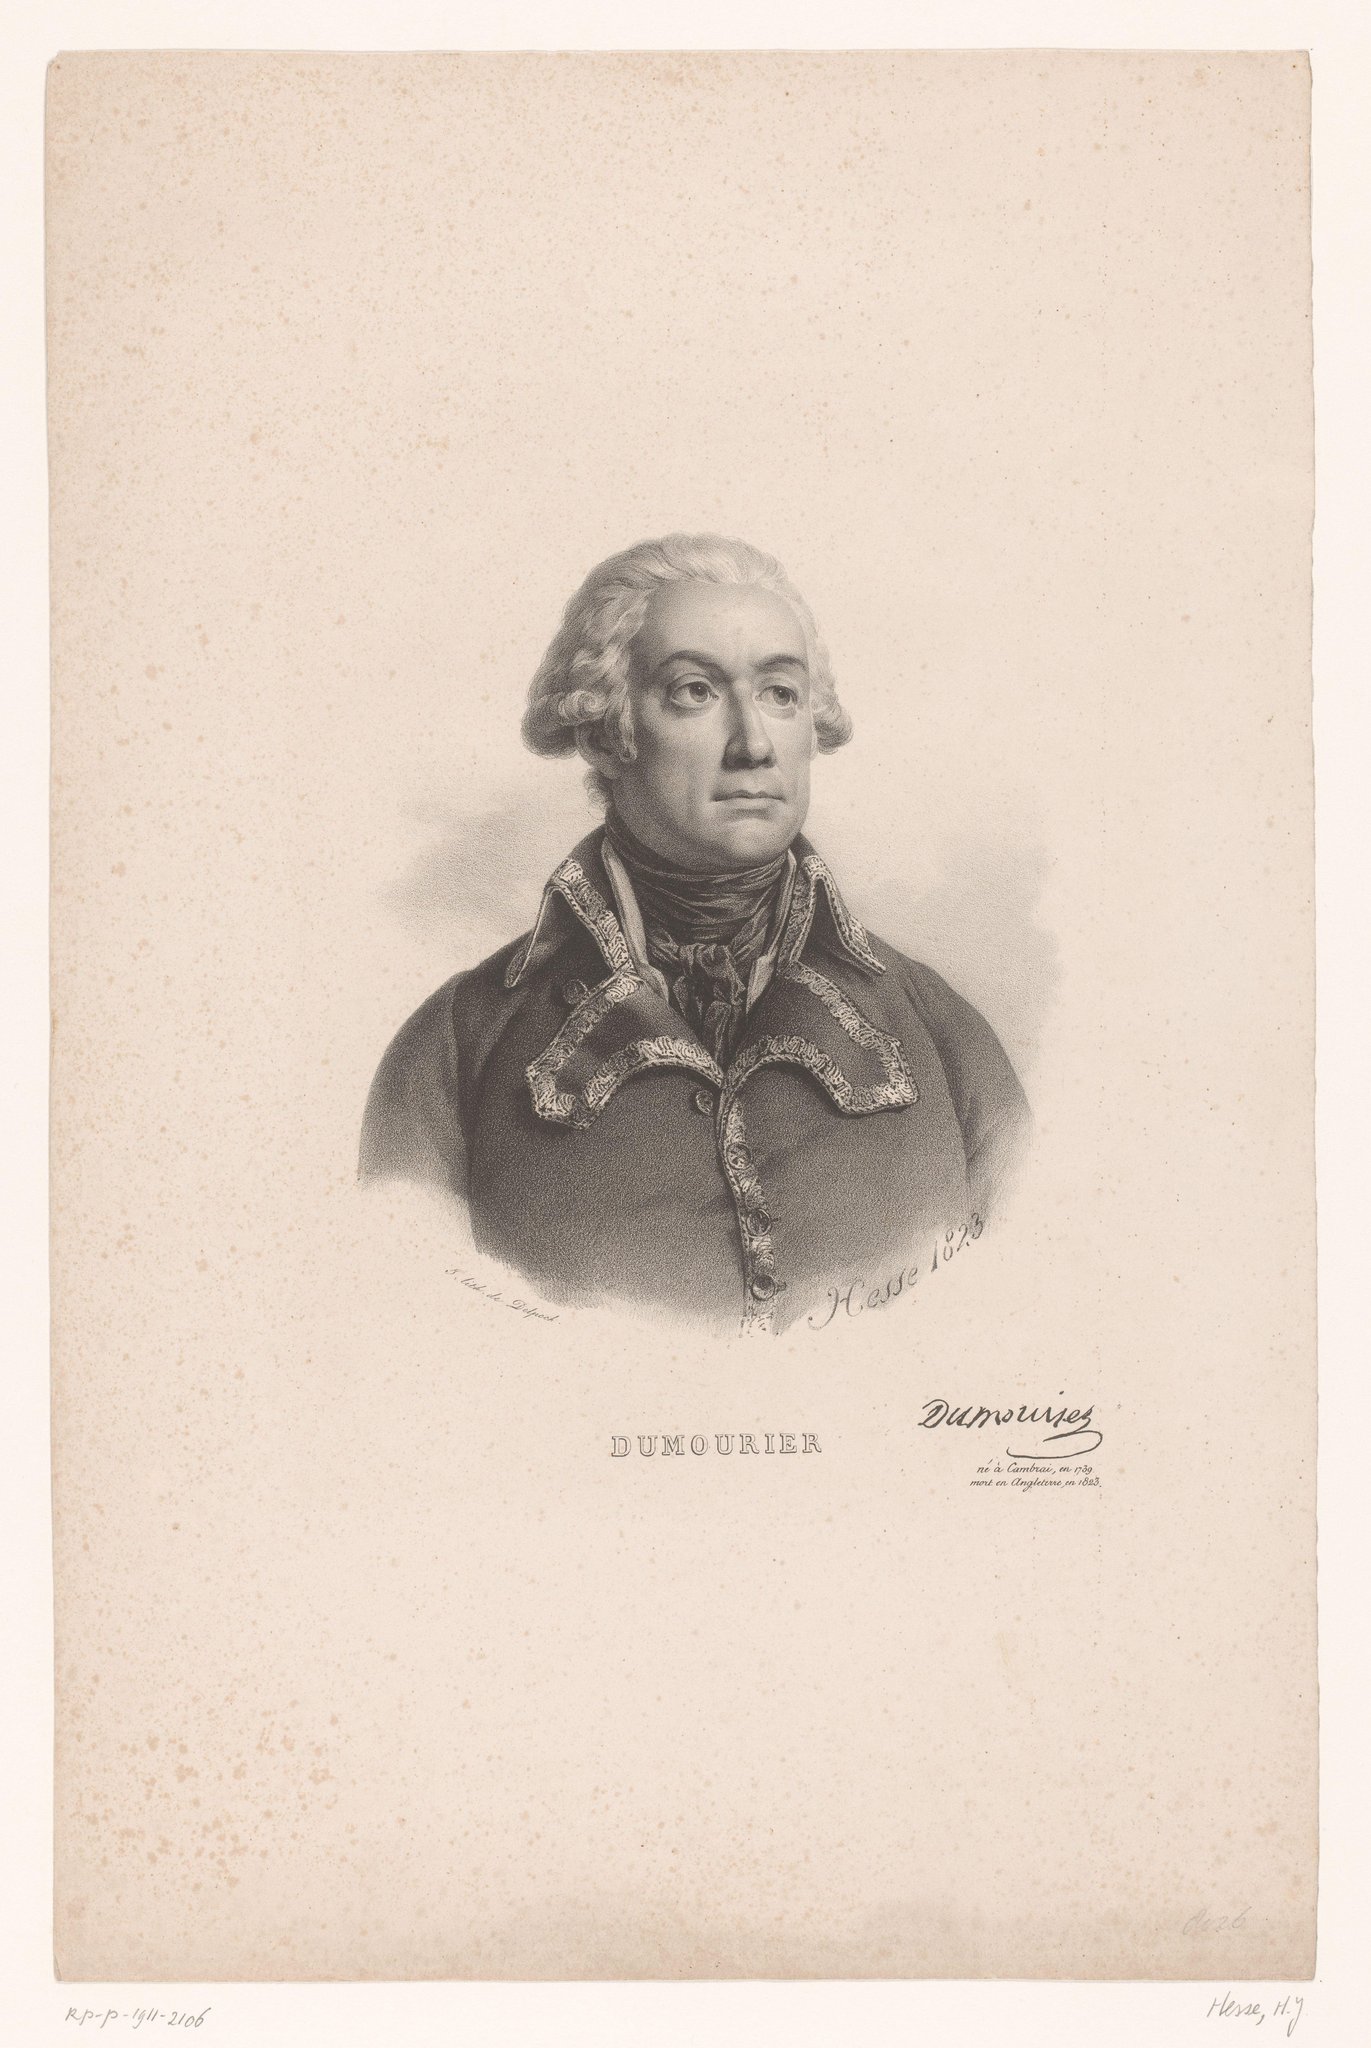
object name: print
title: Dumourier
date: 1823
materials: paper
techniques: lithograph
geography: paris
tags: historical persons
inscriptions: collector's mark: Lugt 2228a